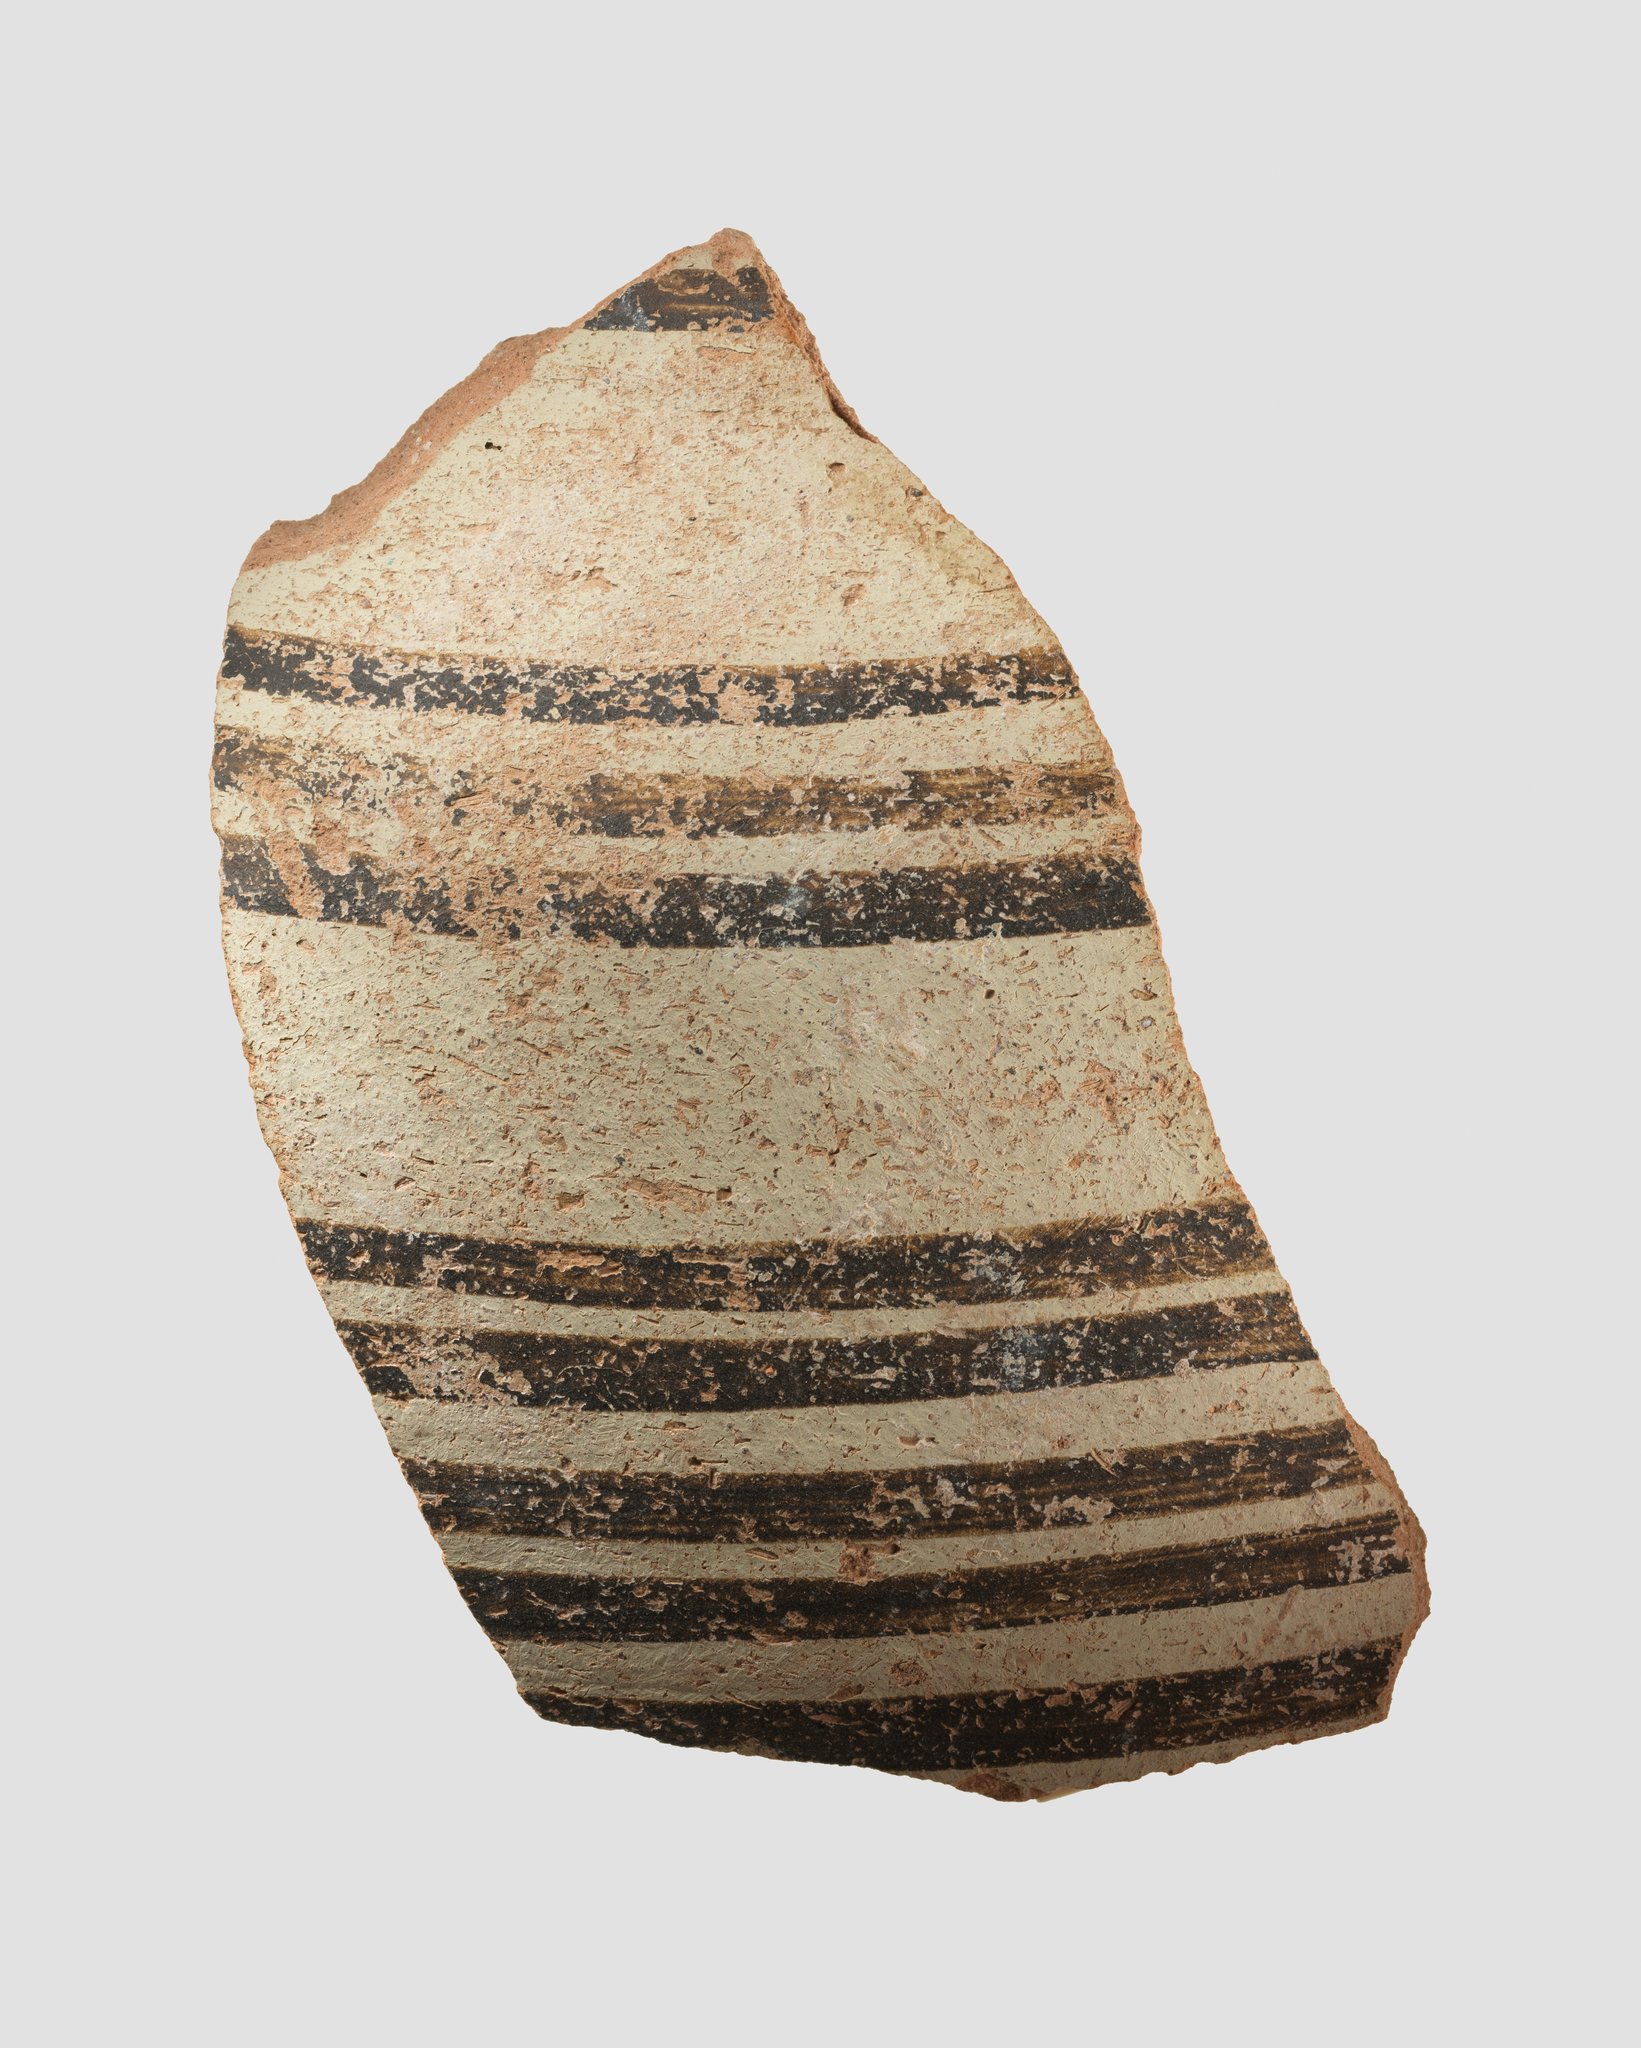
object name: jar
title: Jar sherd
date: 2000-1668 BCE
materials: ceramic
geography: mesopotamia